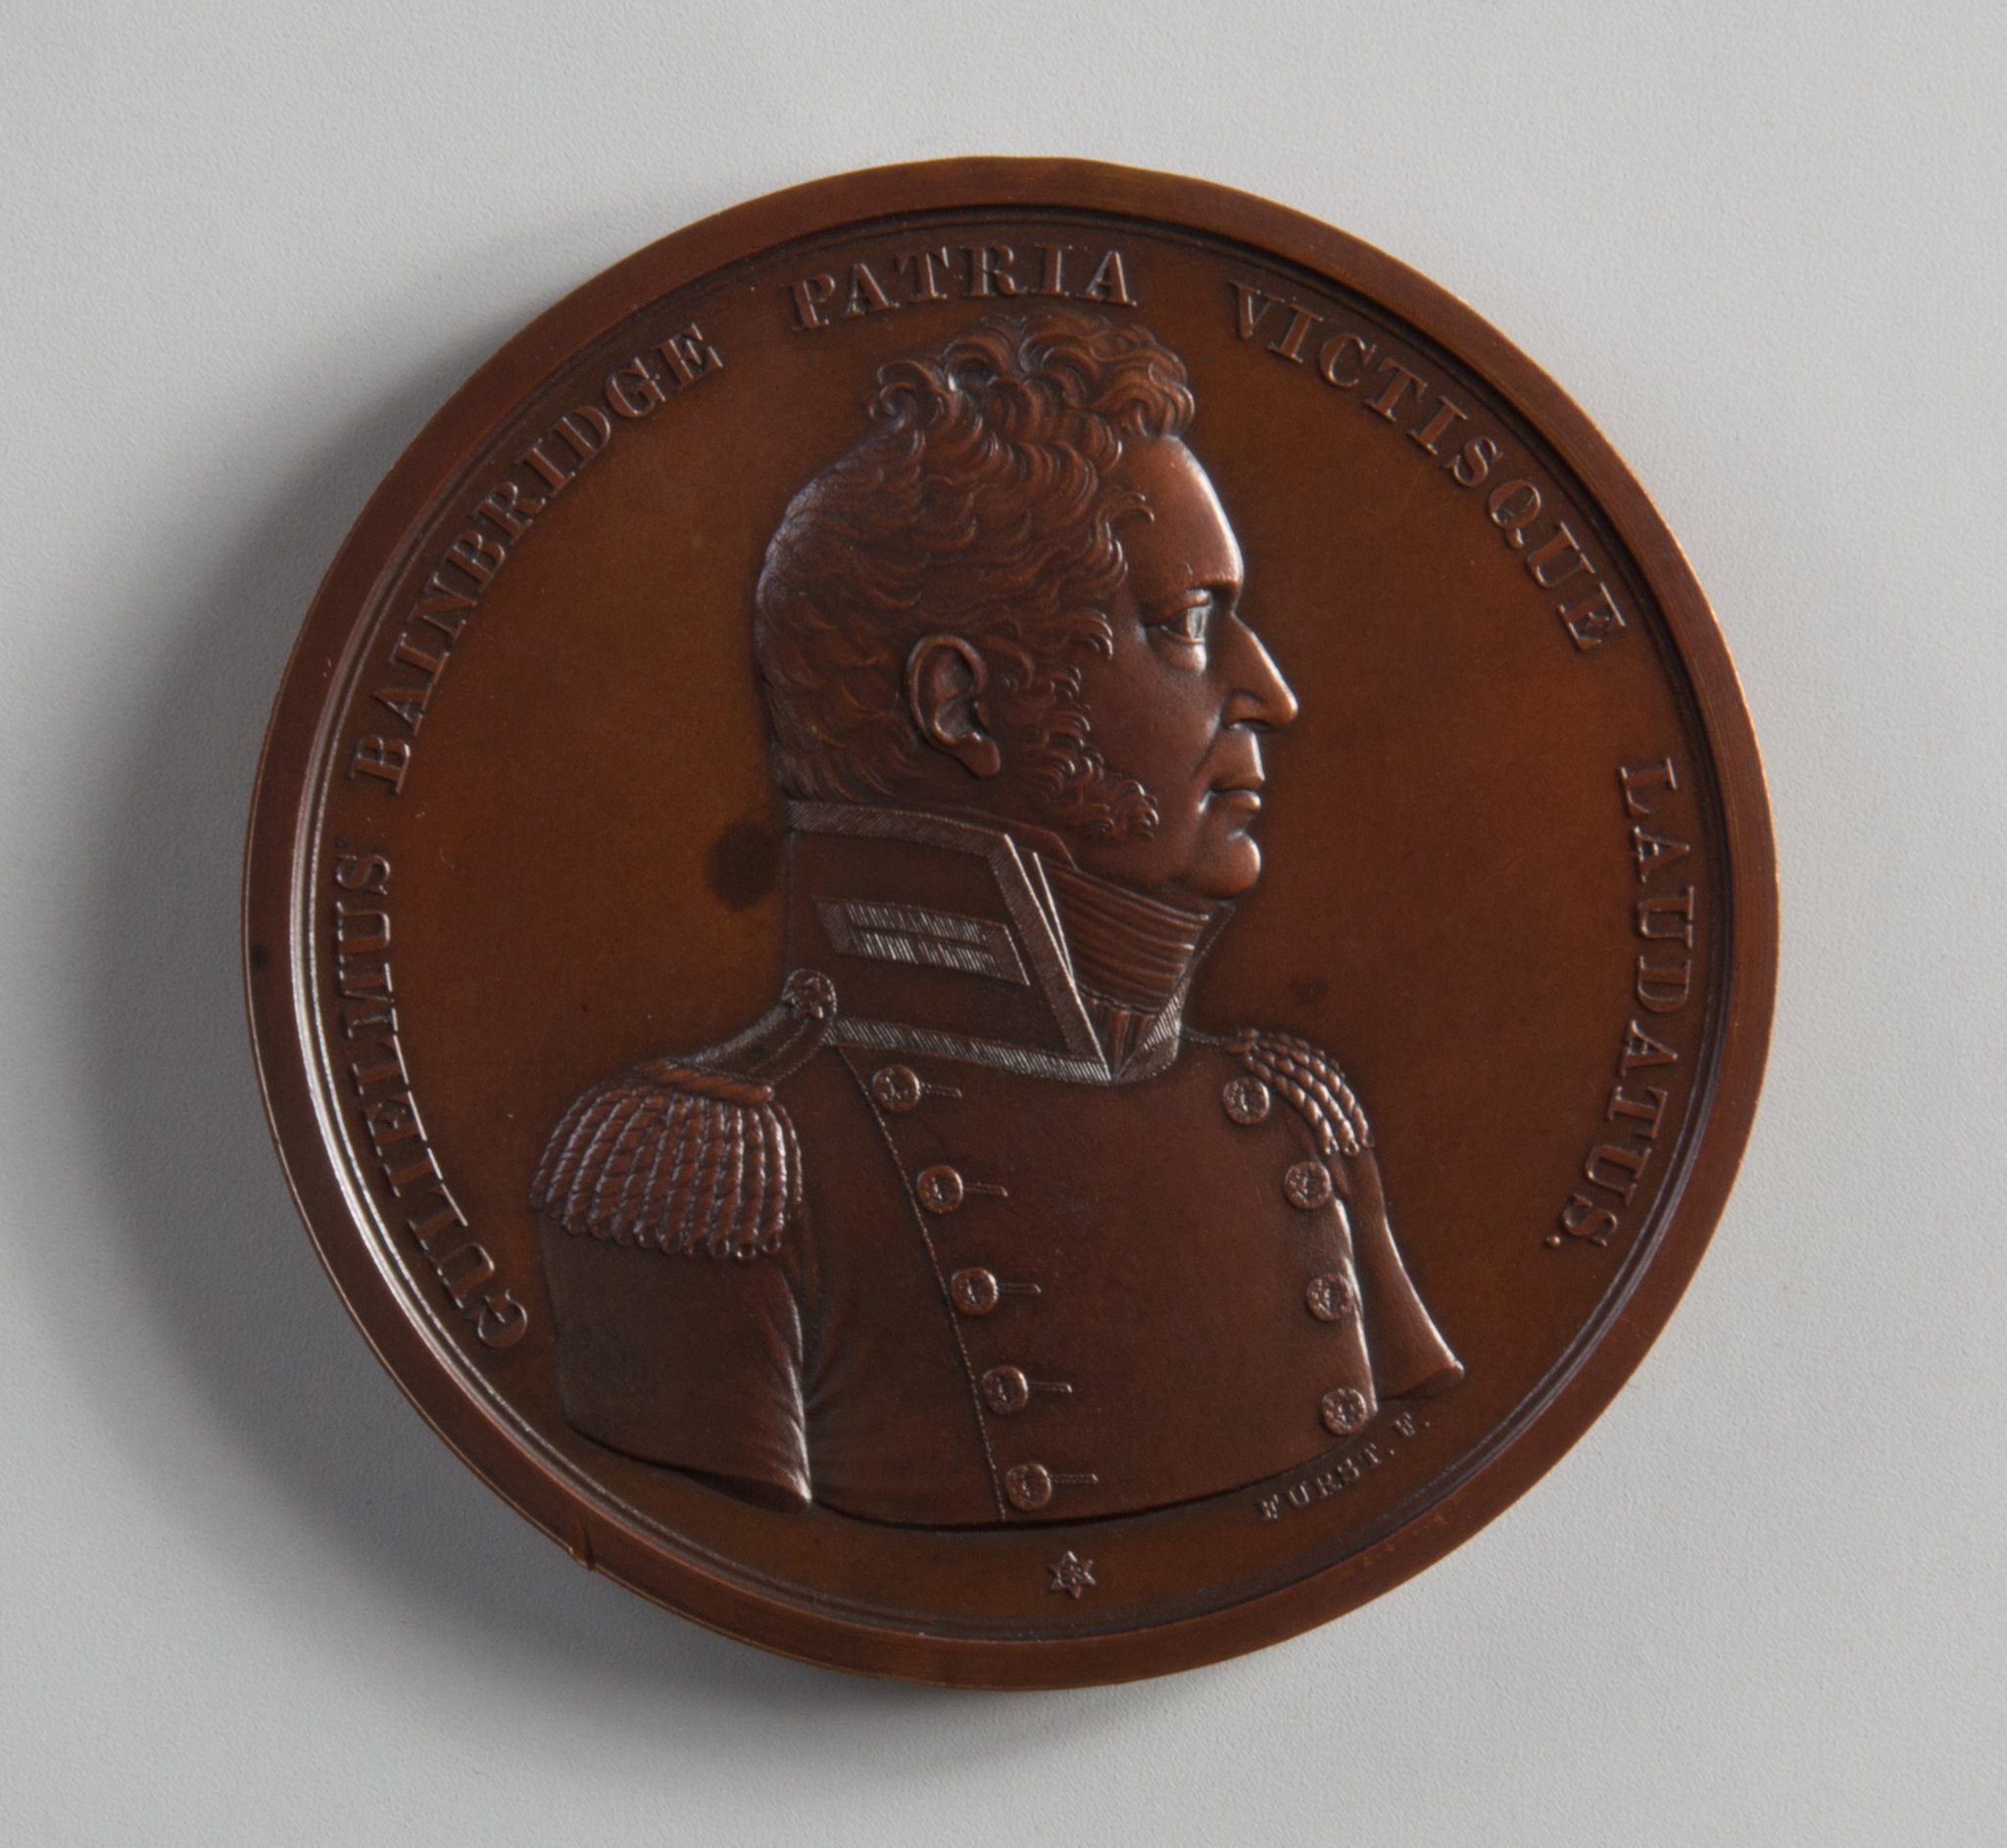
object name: medal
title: Medal of Captain William Bainbridge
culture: american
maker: moritz fürst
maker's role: maker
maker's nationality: hungarian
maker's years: 1782-1882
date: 1800-1830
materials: bronze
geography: united states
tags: men,profiles